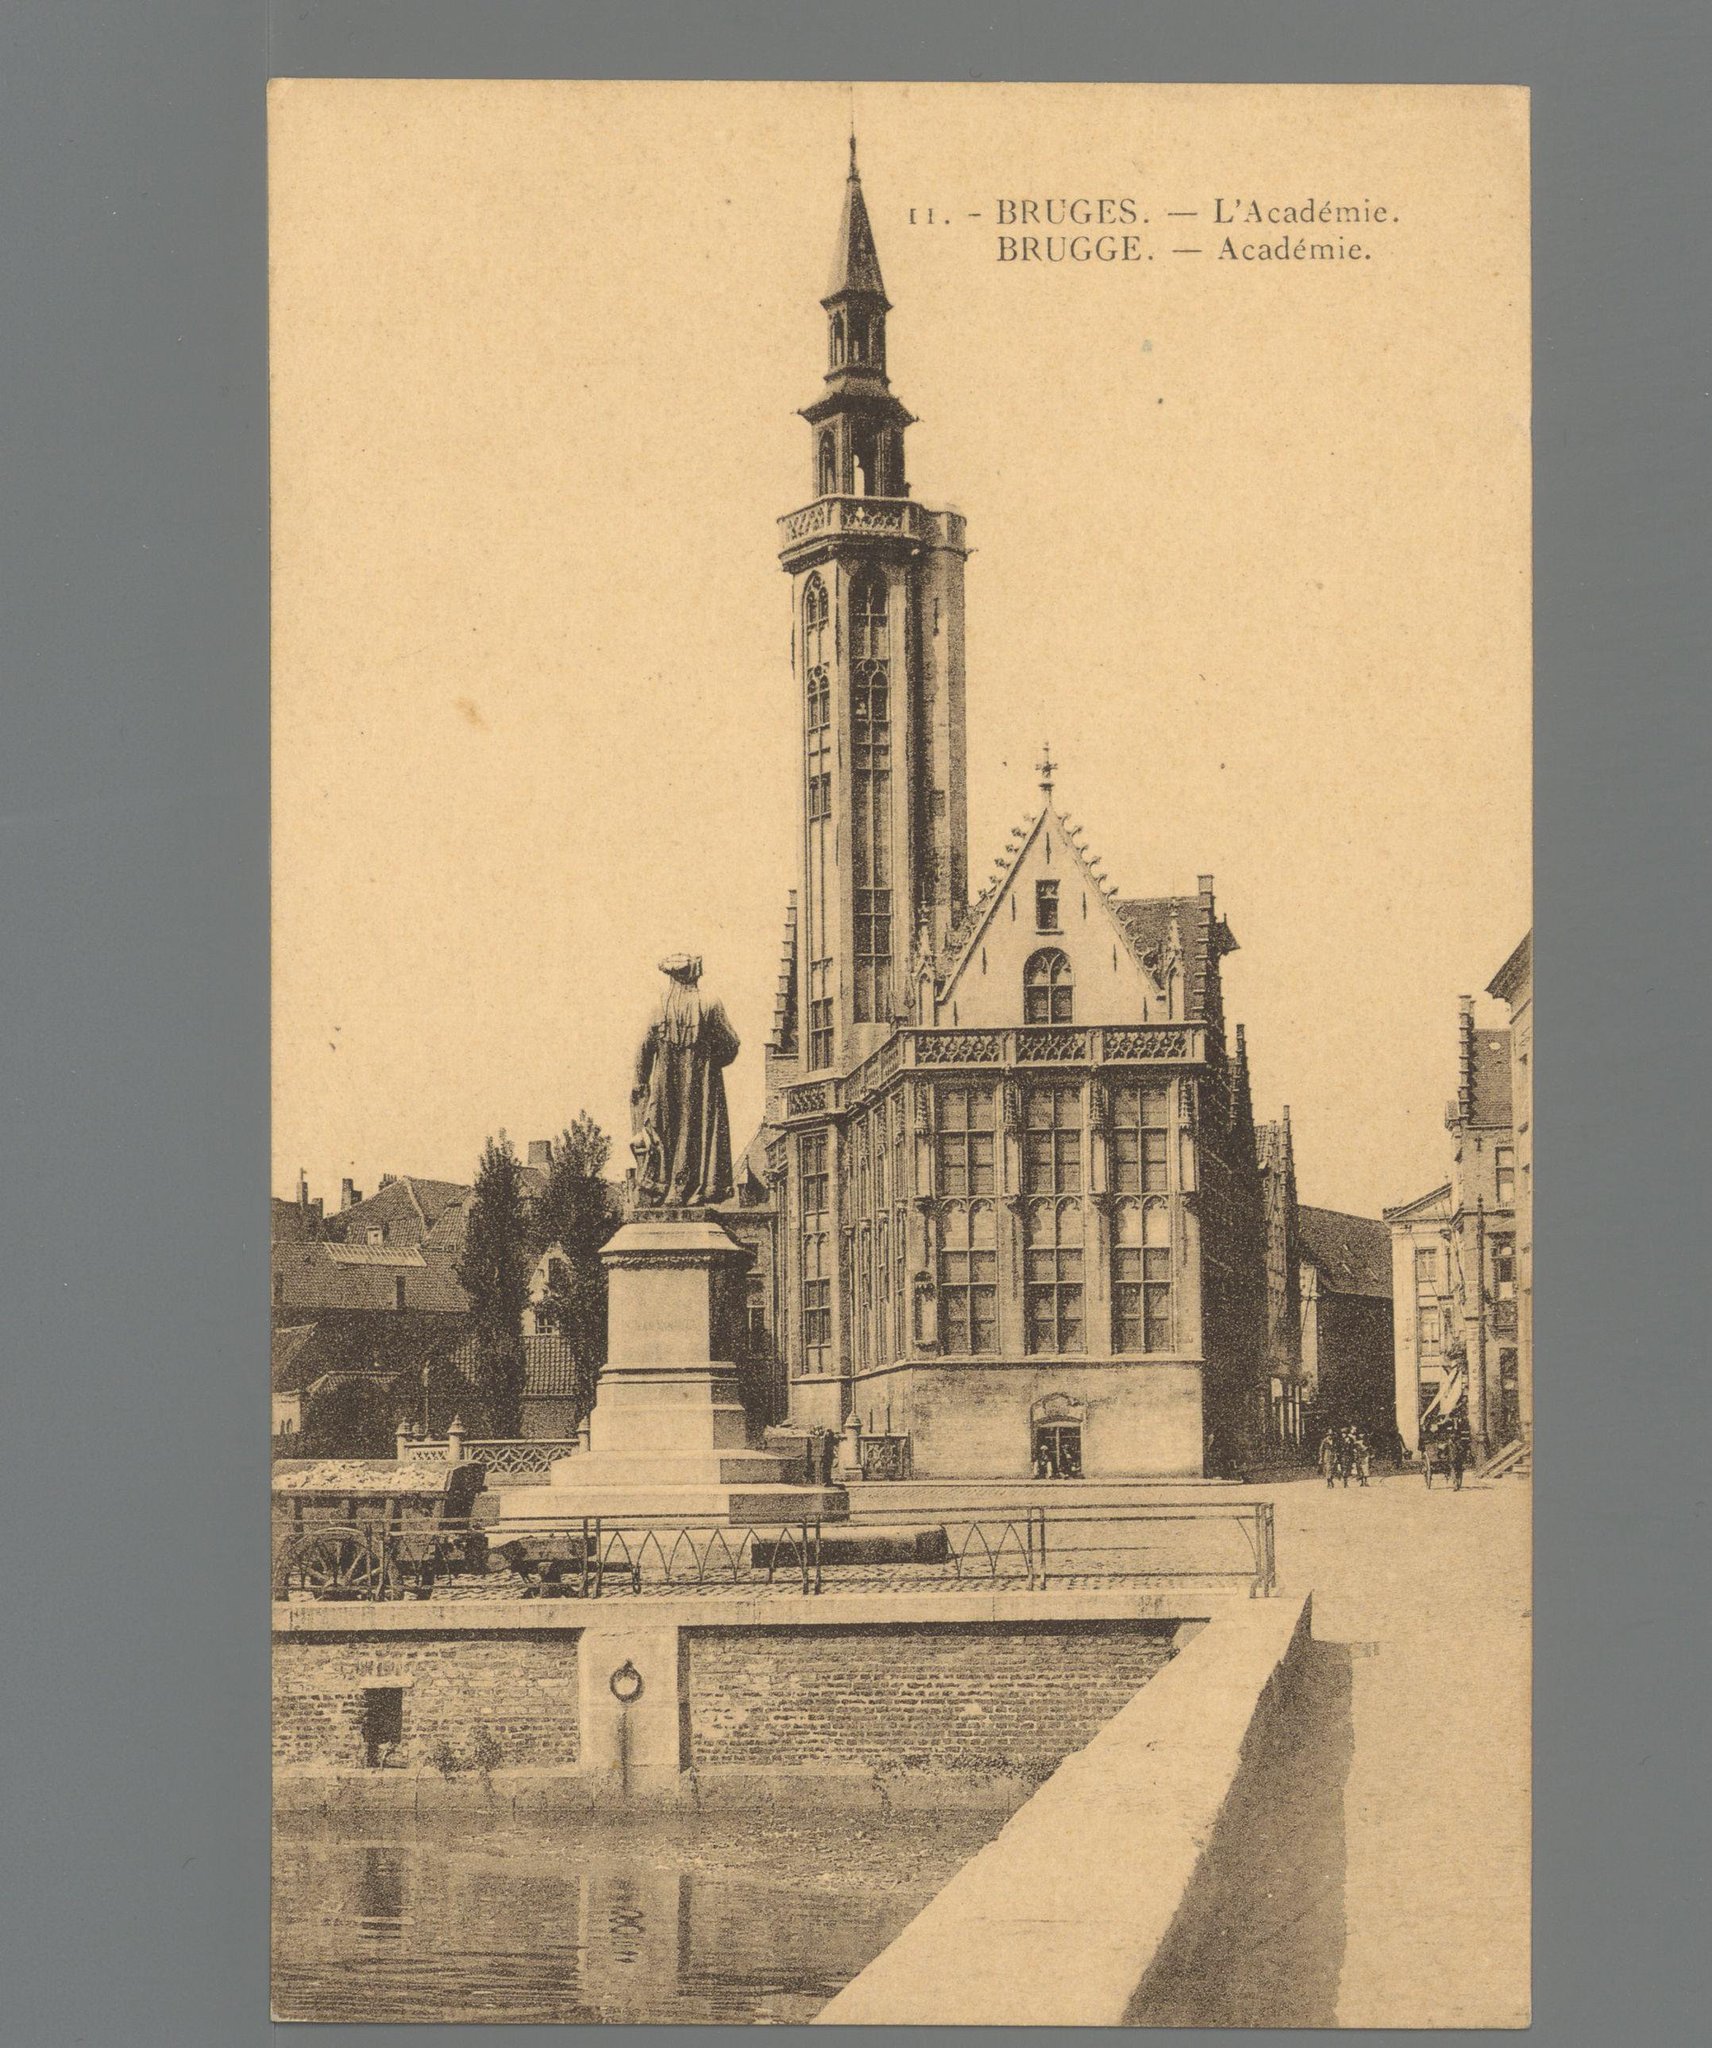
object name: photomechanical print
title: Bruges. L'Académie / Brugge. Académie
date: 1906-1930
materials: cardboard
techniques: photograph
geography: brussels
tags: city-view, and landscape with man-made constructions, monument, statue, edifice, e.g.: public building, department store, bruges